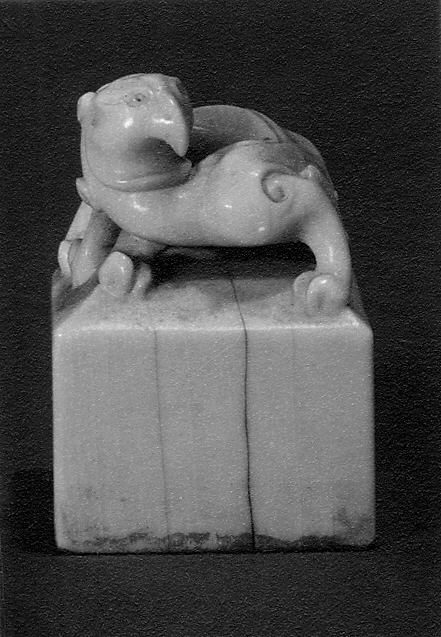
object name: seal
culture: chinese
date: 1701-1800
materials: ivory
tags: animals